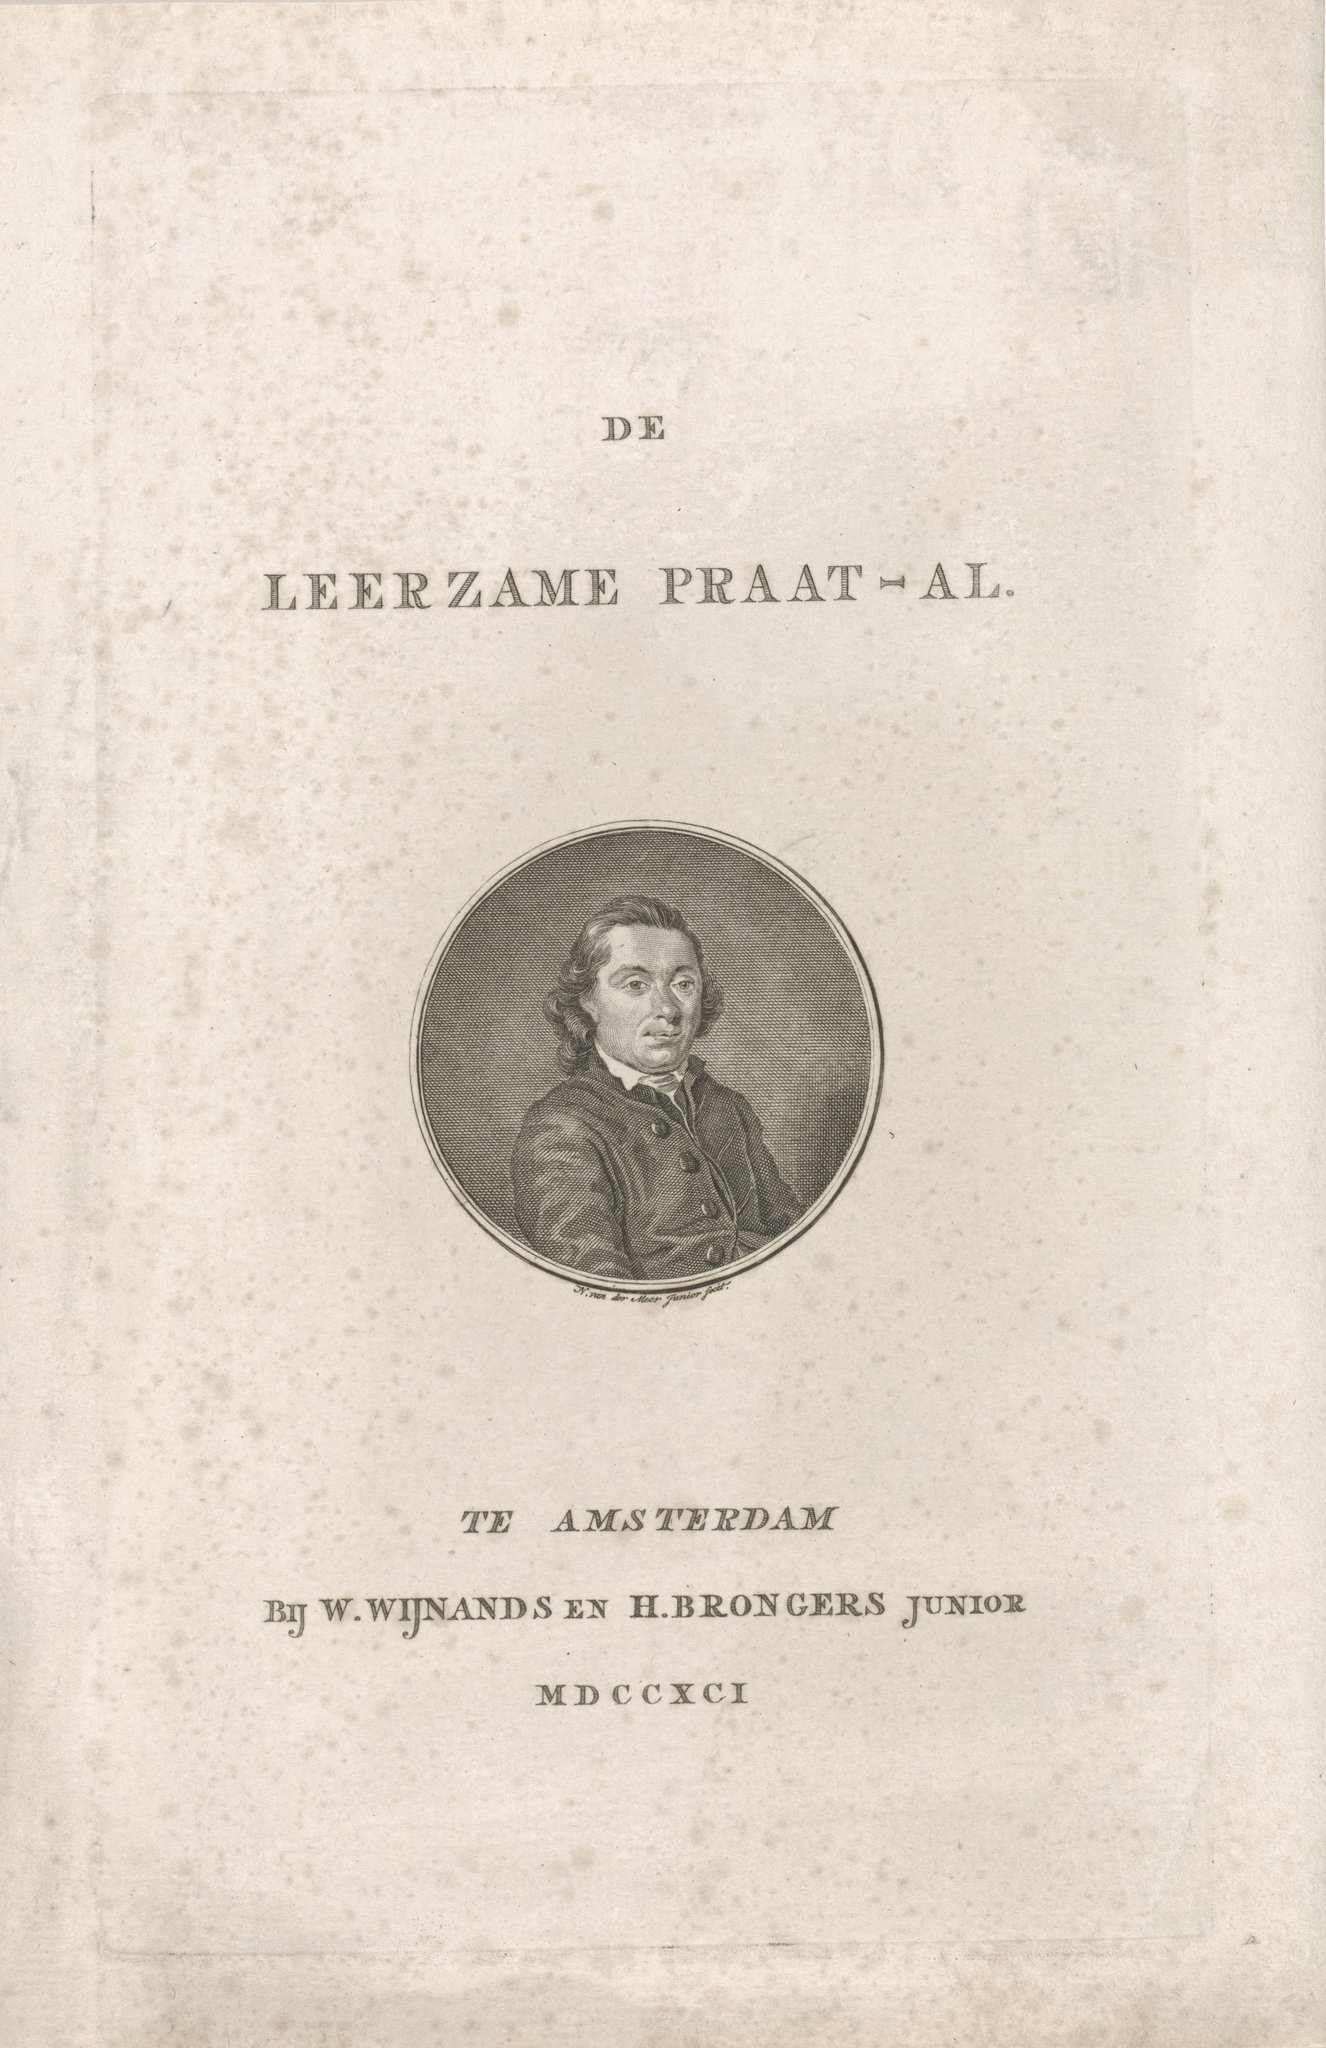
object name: titelblad, titelpagina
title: Titelpagina voor: Bernardus Bosch, De leerzame praat-al, 1791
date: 1791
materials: paper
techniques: etching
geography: amsterdam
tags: deventer, the hague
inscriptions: collector's mark: Lugt 2228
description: Titelpagina voor: Bosch, Bernardus. De leerzame praat-al. Amsterdam: Wijnand Wijnands en Hendrik Brongers junior, 1791, dl. 2.